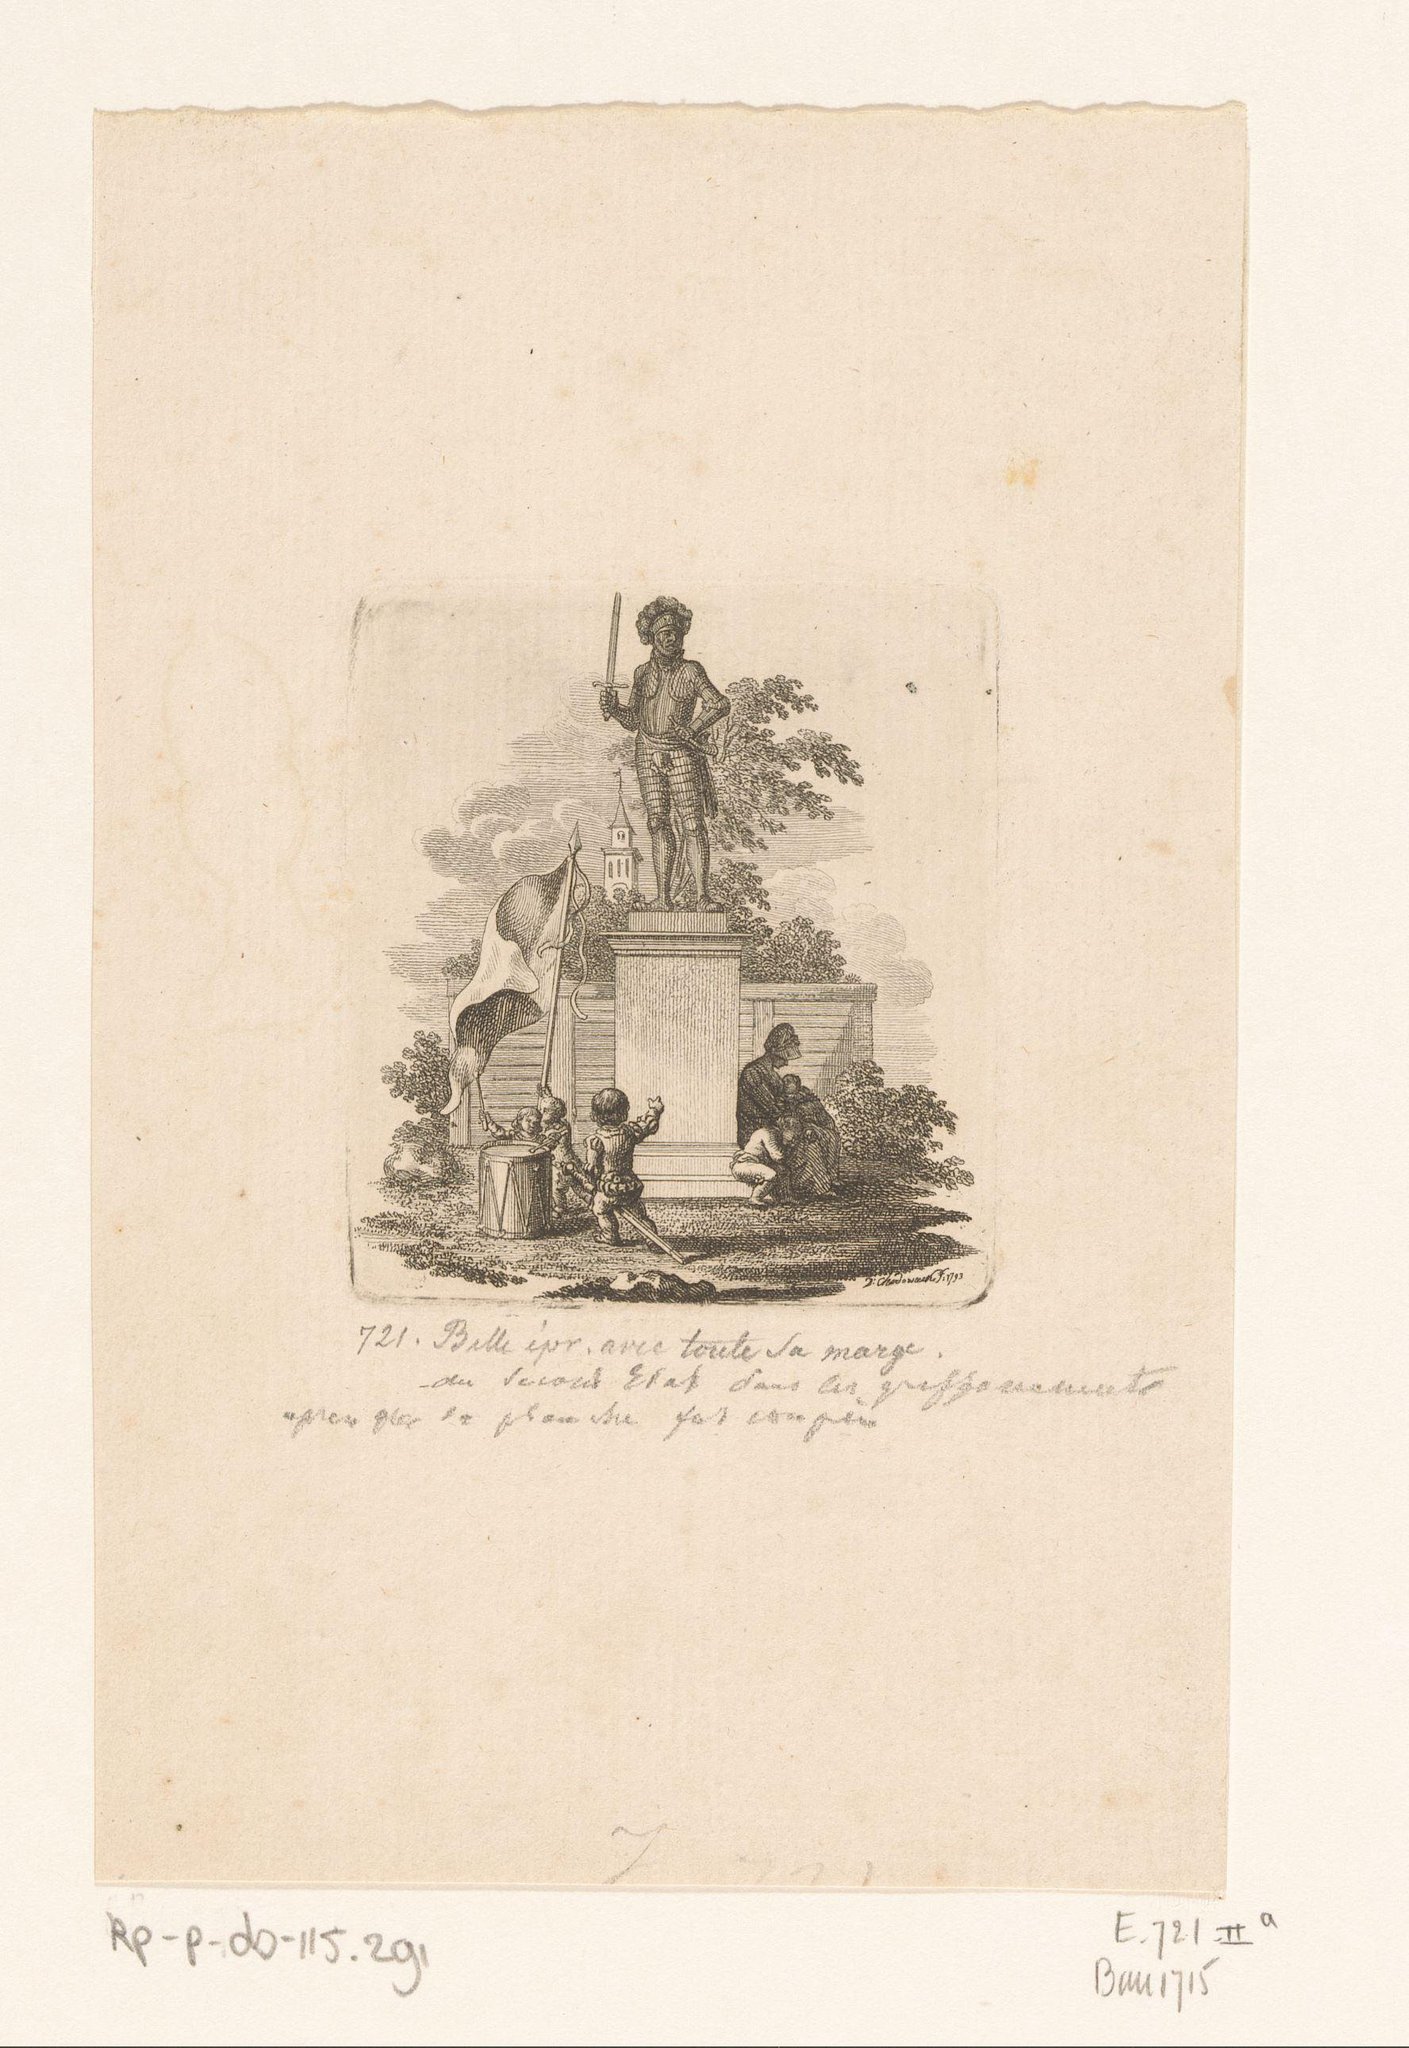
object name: print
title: Verering van het standbeeld van de grote Roland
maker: daniel nikolaus chodowiecki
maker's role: draughtsman, print maker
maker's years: 1726-1801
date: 1793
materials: paper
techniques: etching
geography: berlin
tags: breasts giving milk, roland, monument, statue, drum (musical instrument) - cc - out of doors, flag, colours (as symbol of the state, etc.)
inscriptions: collector's mark: Lugt 2228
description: Latere staat gebruikt voor: Wächter, Leonhard. Historien von Leonhard Waechter (...). Hamburg: Bachmann und Gundermann, 1794.